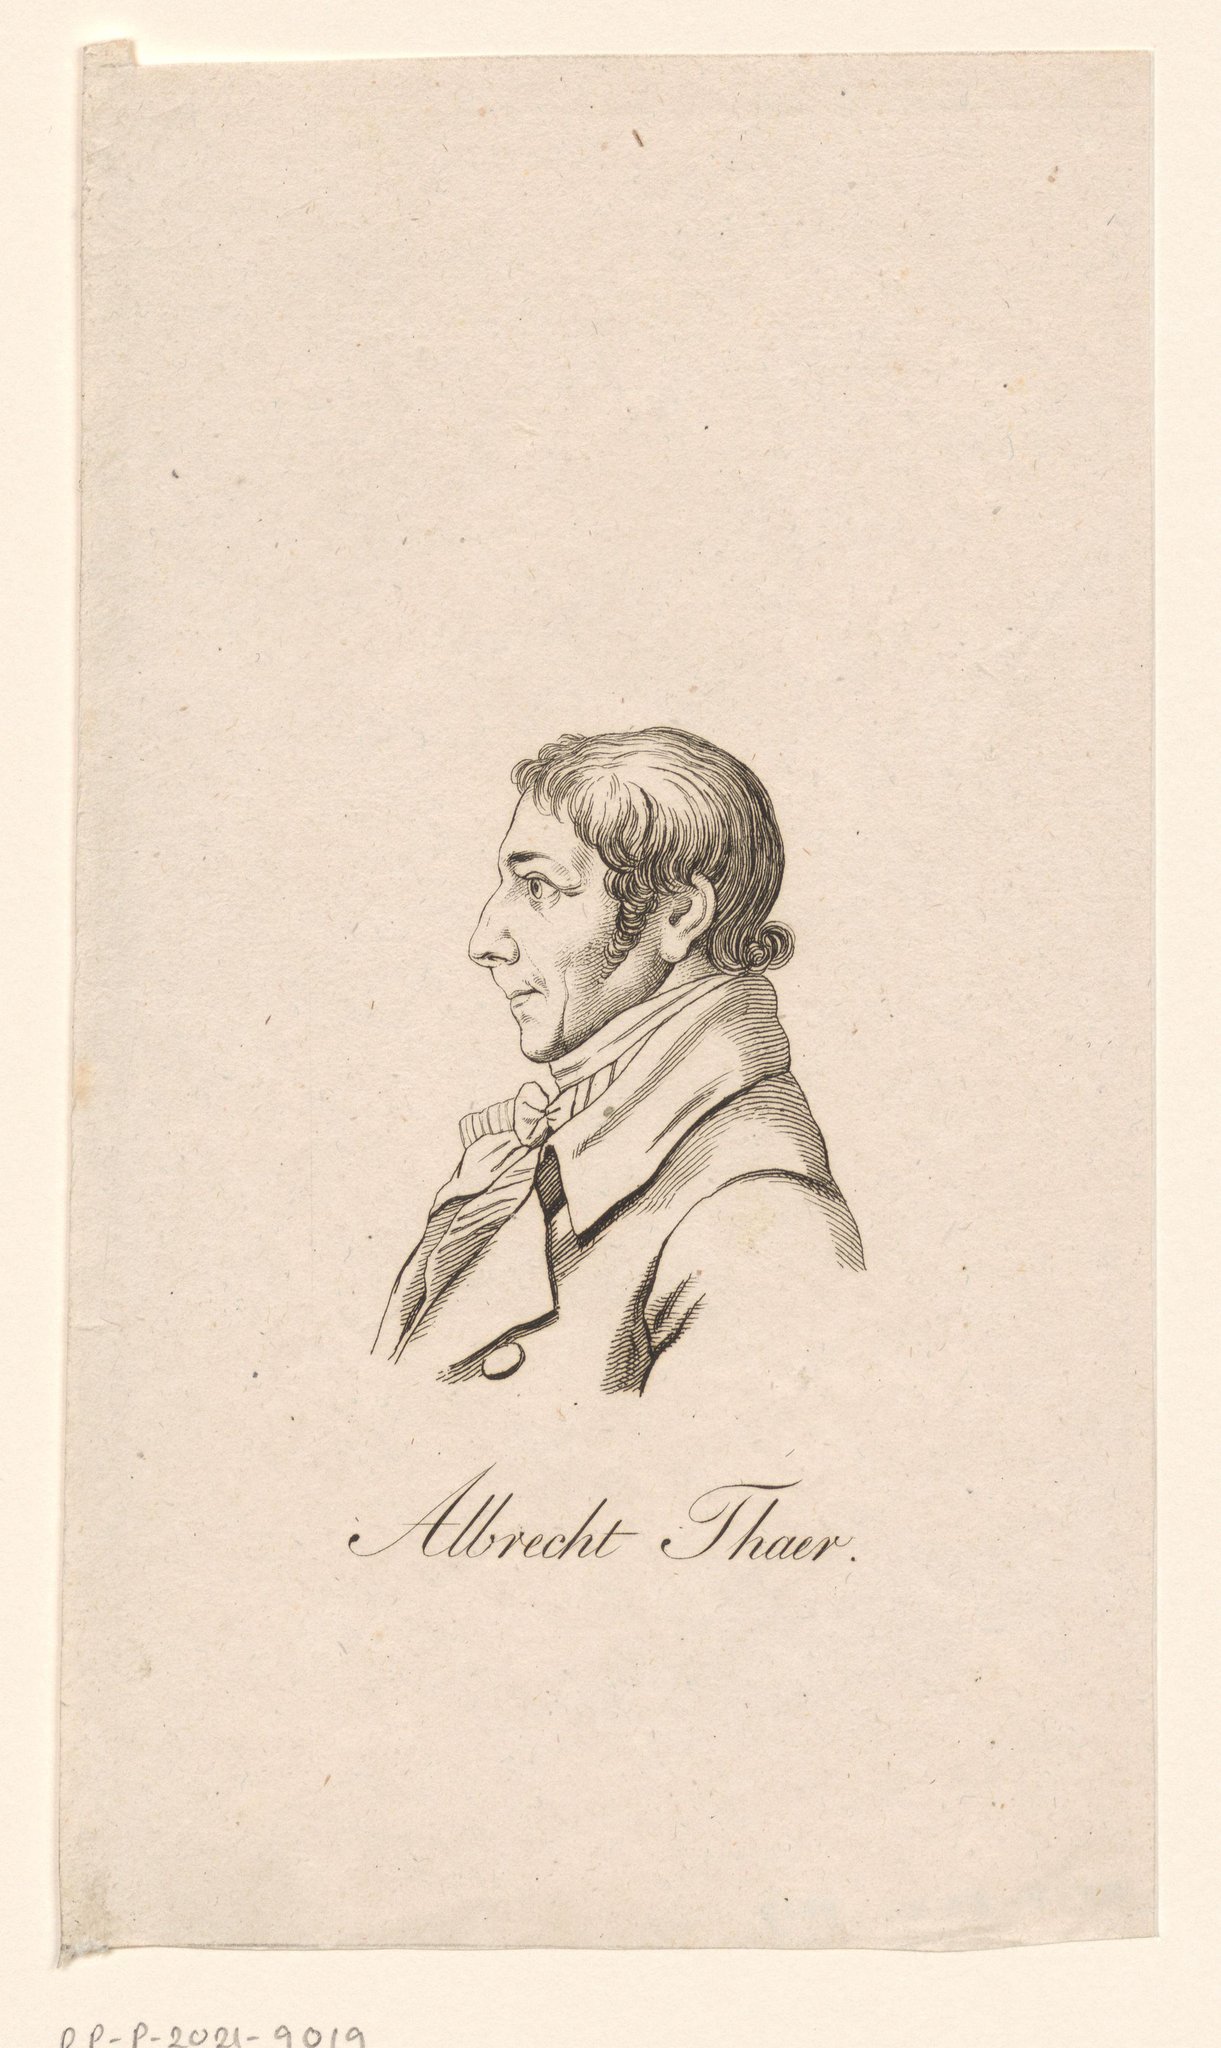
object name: print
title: Portret van Albrecht Daniel Thaer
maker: Anonymous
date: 1800-1824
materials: paper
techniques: etching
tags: albrecht daniel thaer, historical persons, physician, doctor